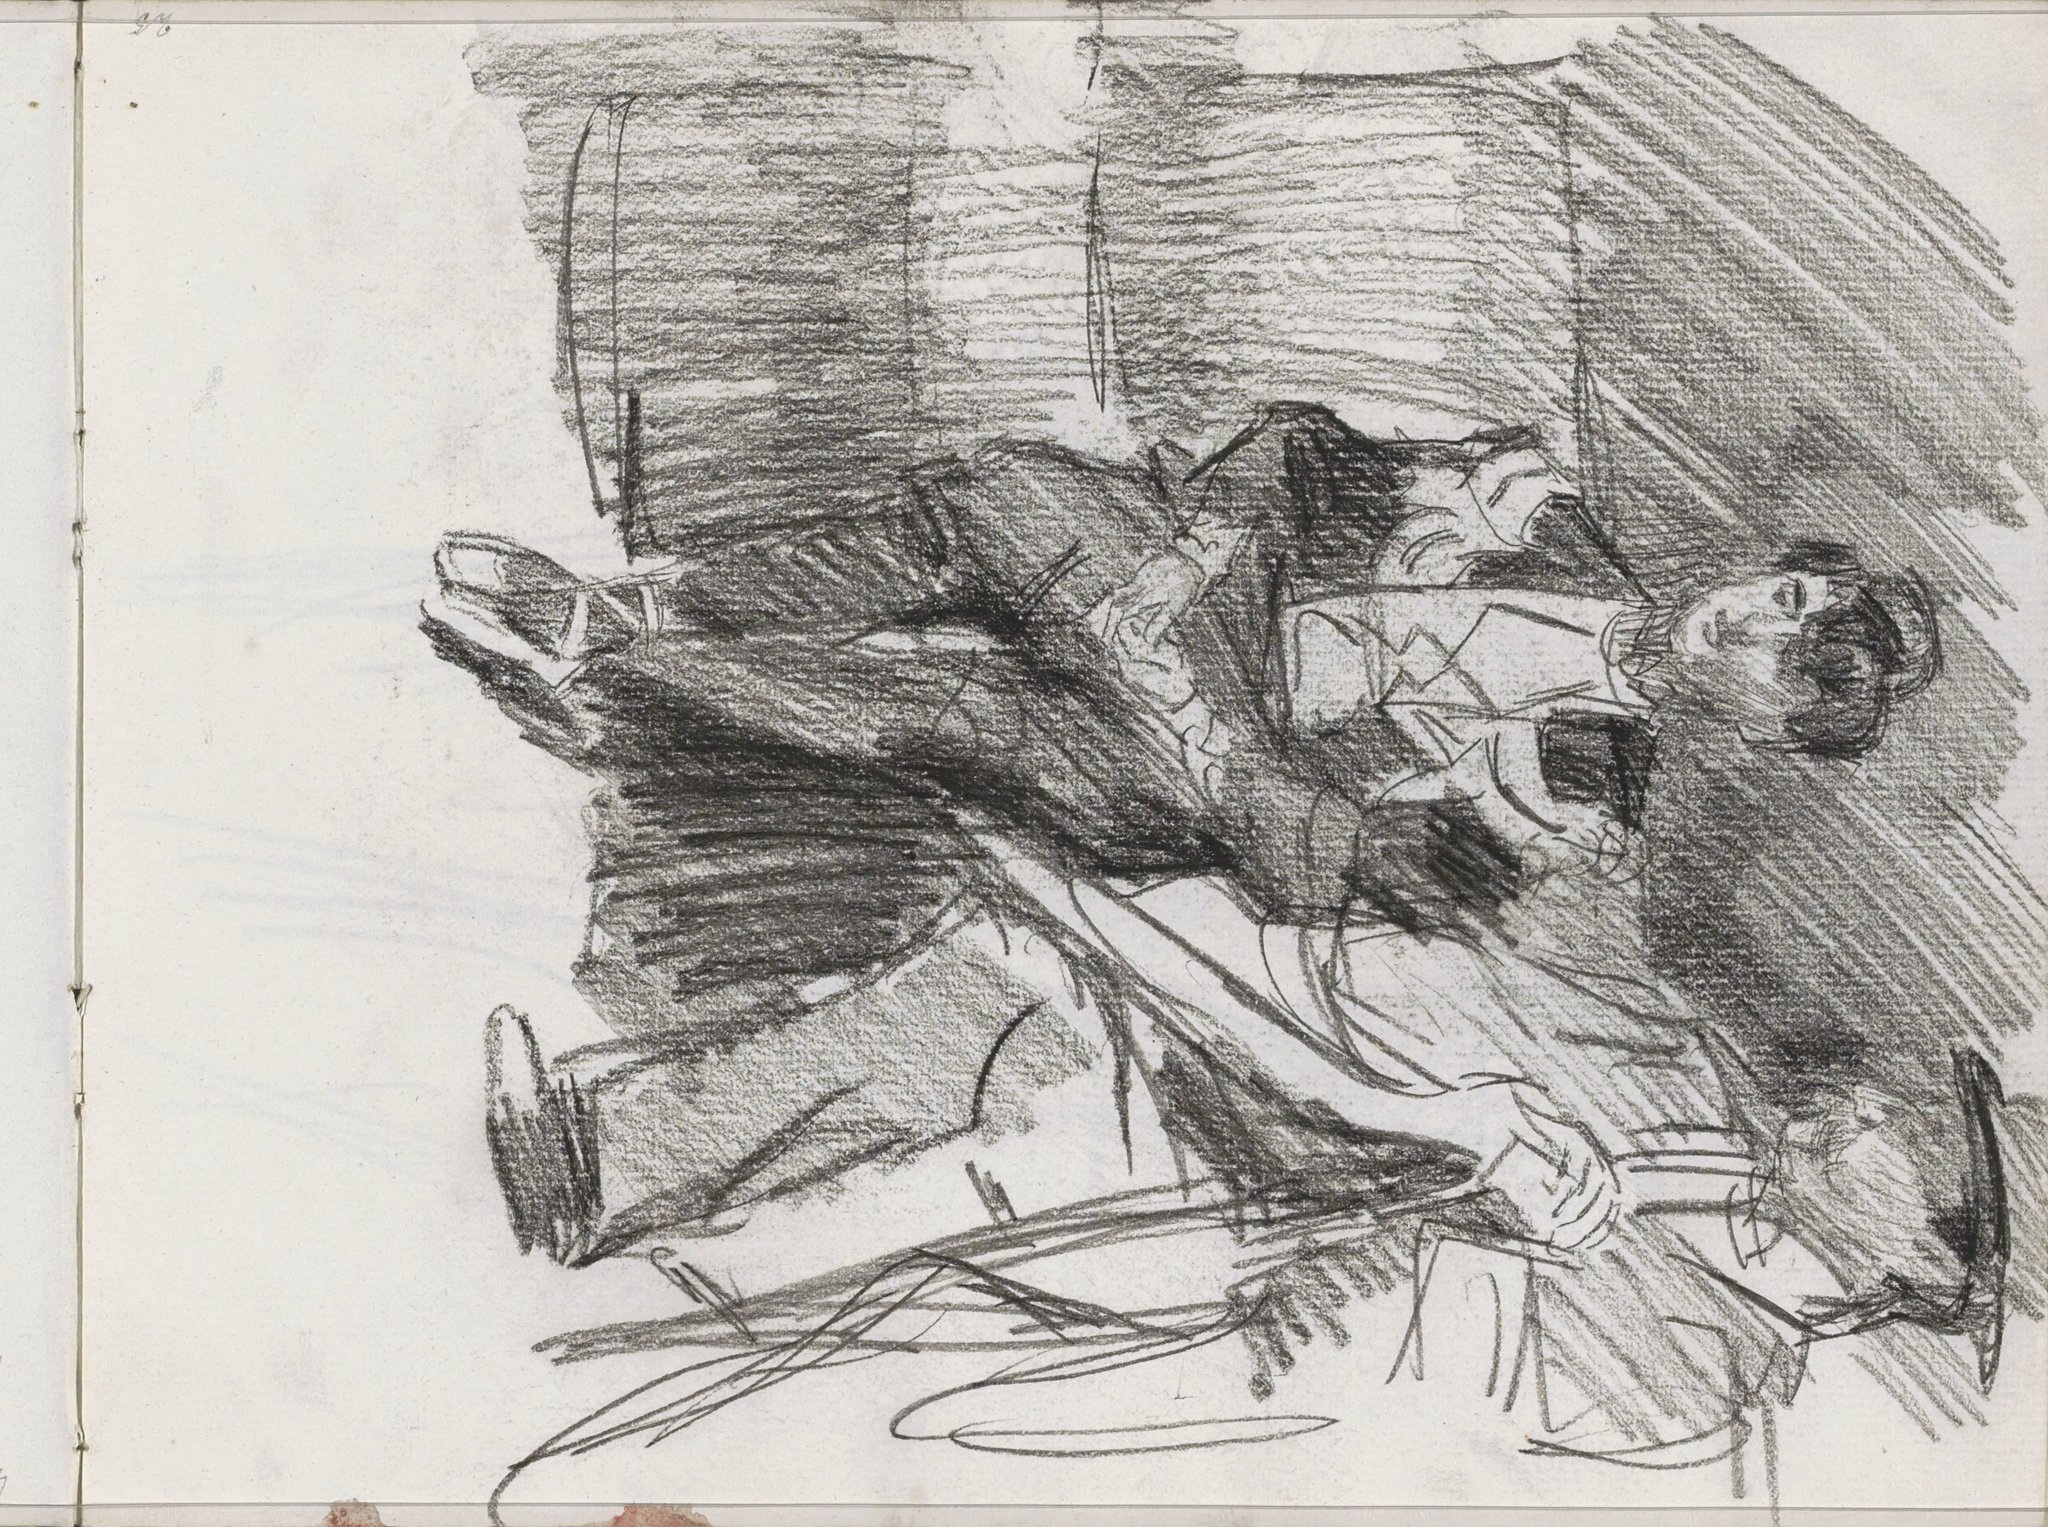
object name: sketchbook leaf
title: Danseres naast een man, zittend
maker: isaac israels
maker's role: draughtsman, painter, print maker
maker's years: 1865-1934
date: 1875-1934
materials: chalk, paper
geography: the hague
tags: adult man (+ sitting), adult woman (+ sitting), female dancer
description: Blad 7 recto uit schetsboek XXII met 30 bladen.